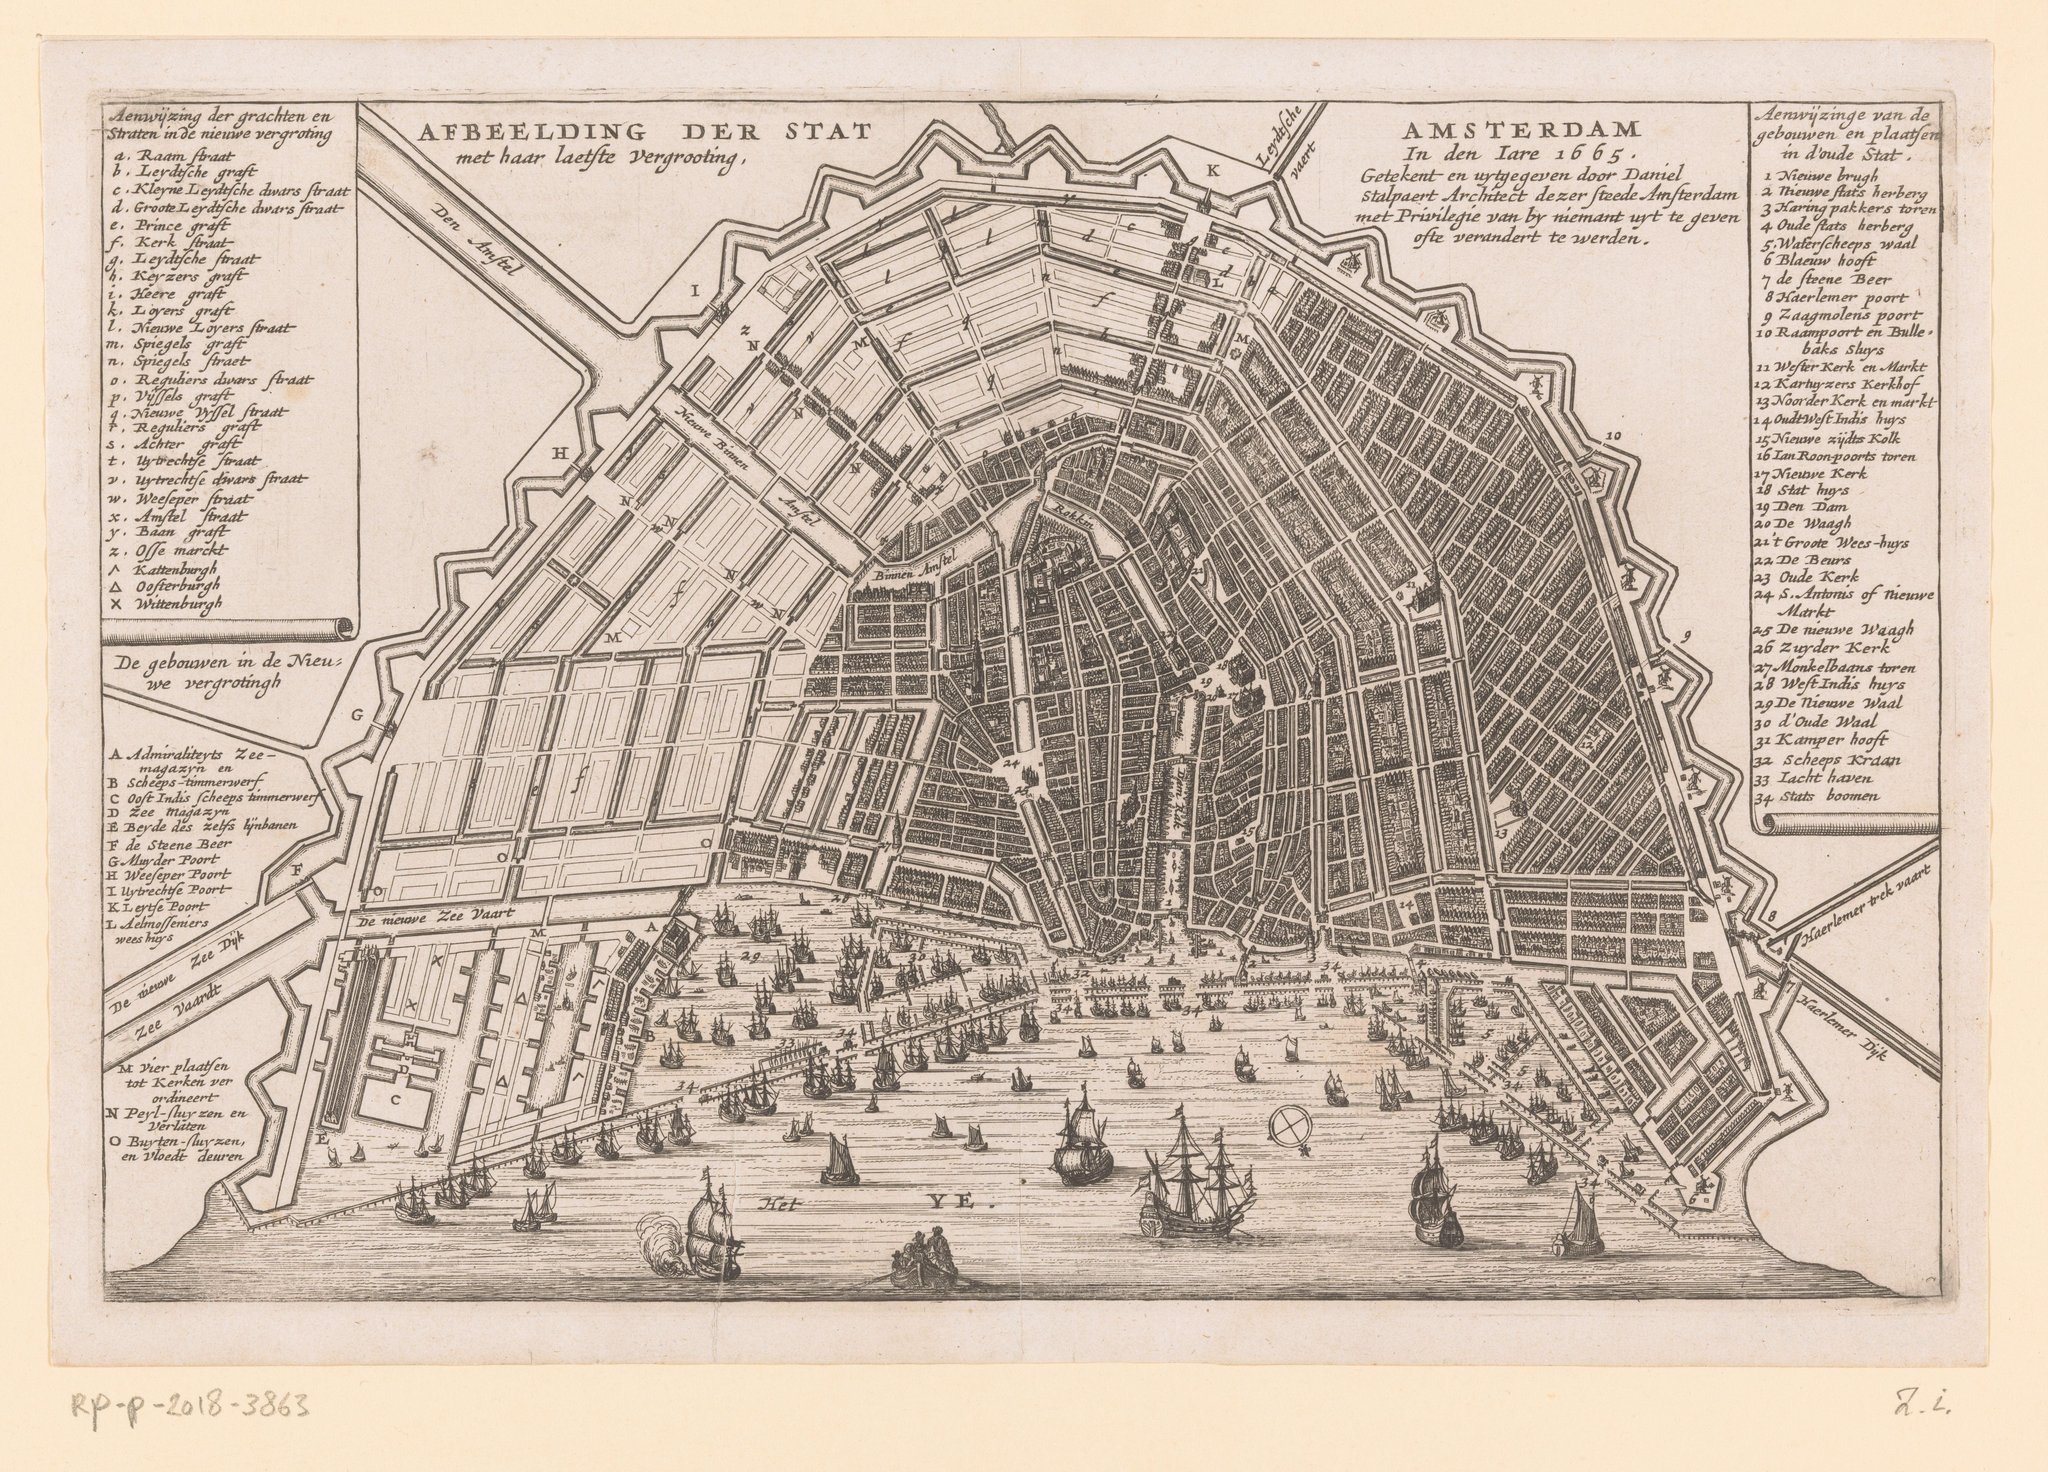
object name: print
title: Plattegrond van Amsterdam in het jaar 1665 na de vierde uitleg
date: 1665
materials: paper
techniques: etching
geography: amsterdam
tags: maps of cities, amsterdam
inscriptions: date